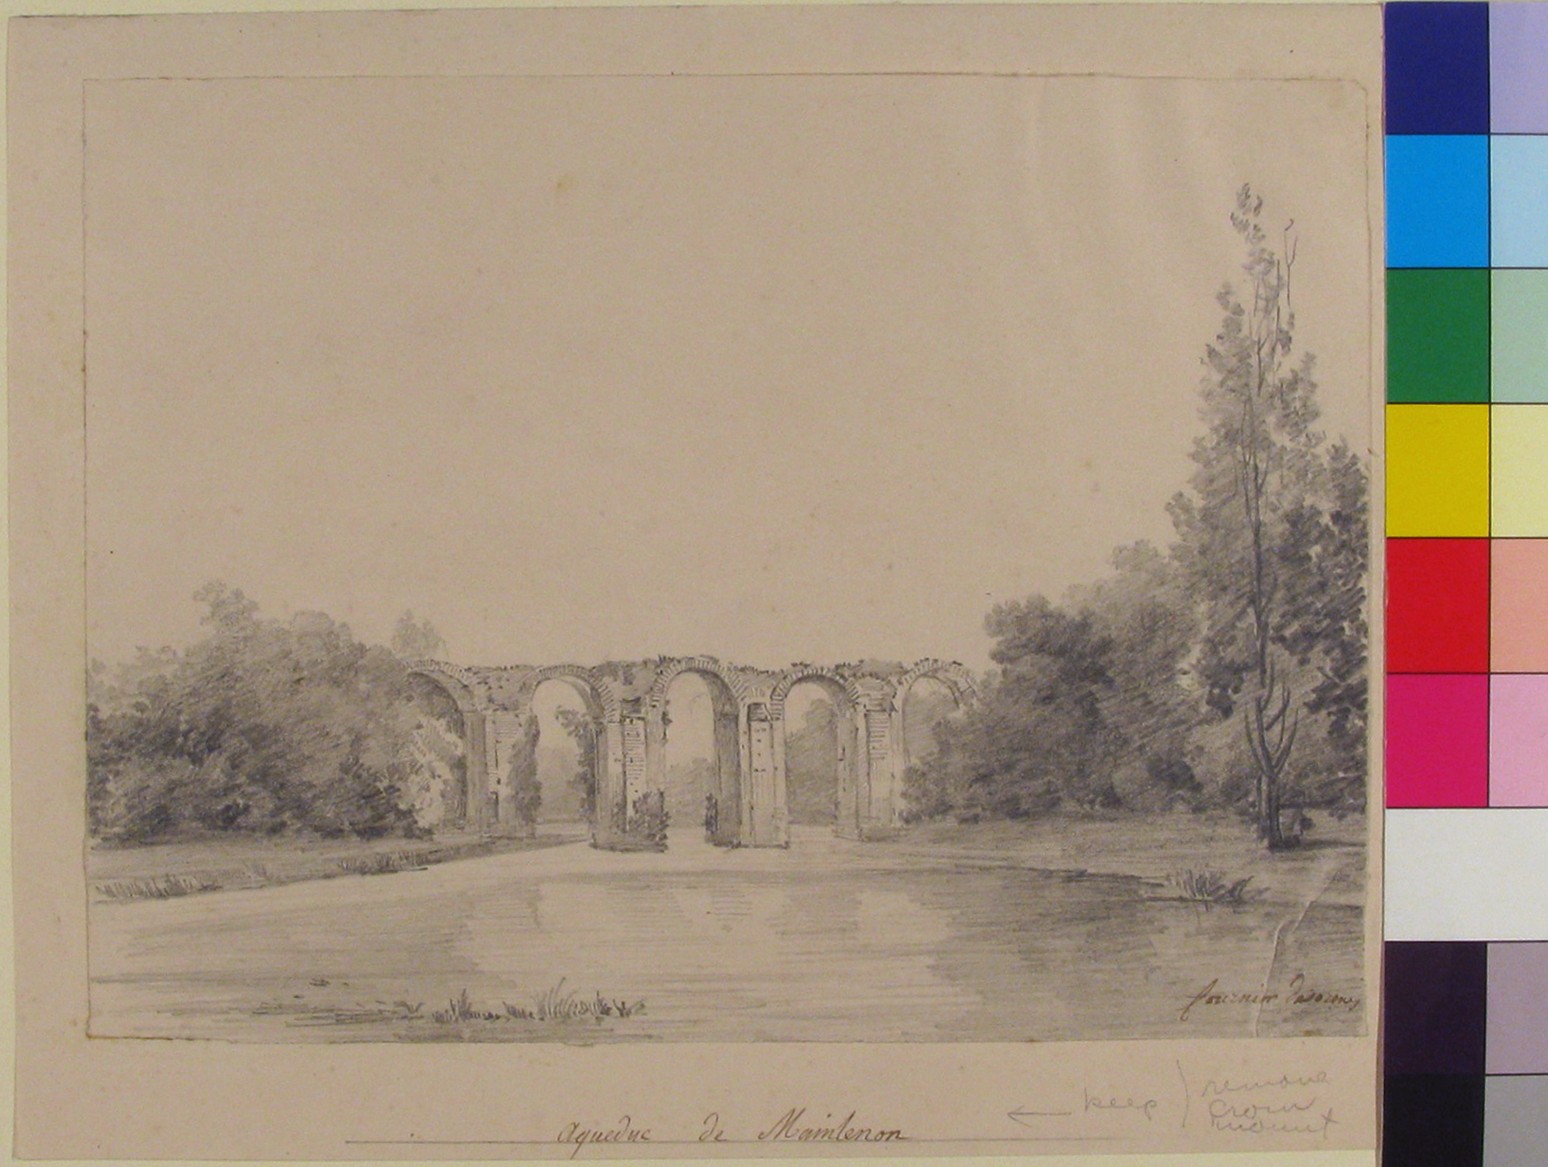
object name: drawing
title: Aqueduc de Maintenon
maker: charles fournier des ormes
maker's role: artist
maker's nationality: french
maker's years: 1777-1850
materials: graphite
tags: aqueducts